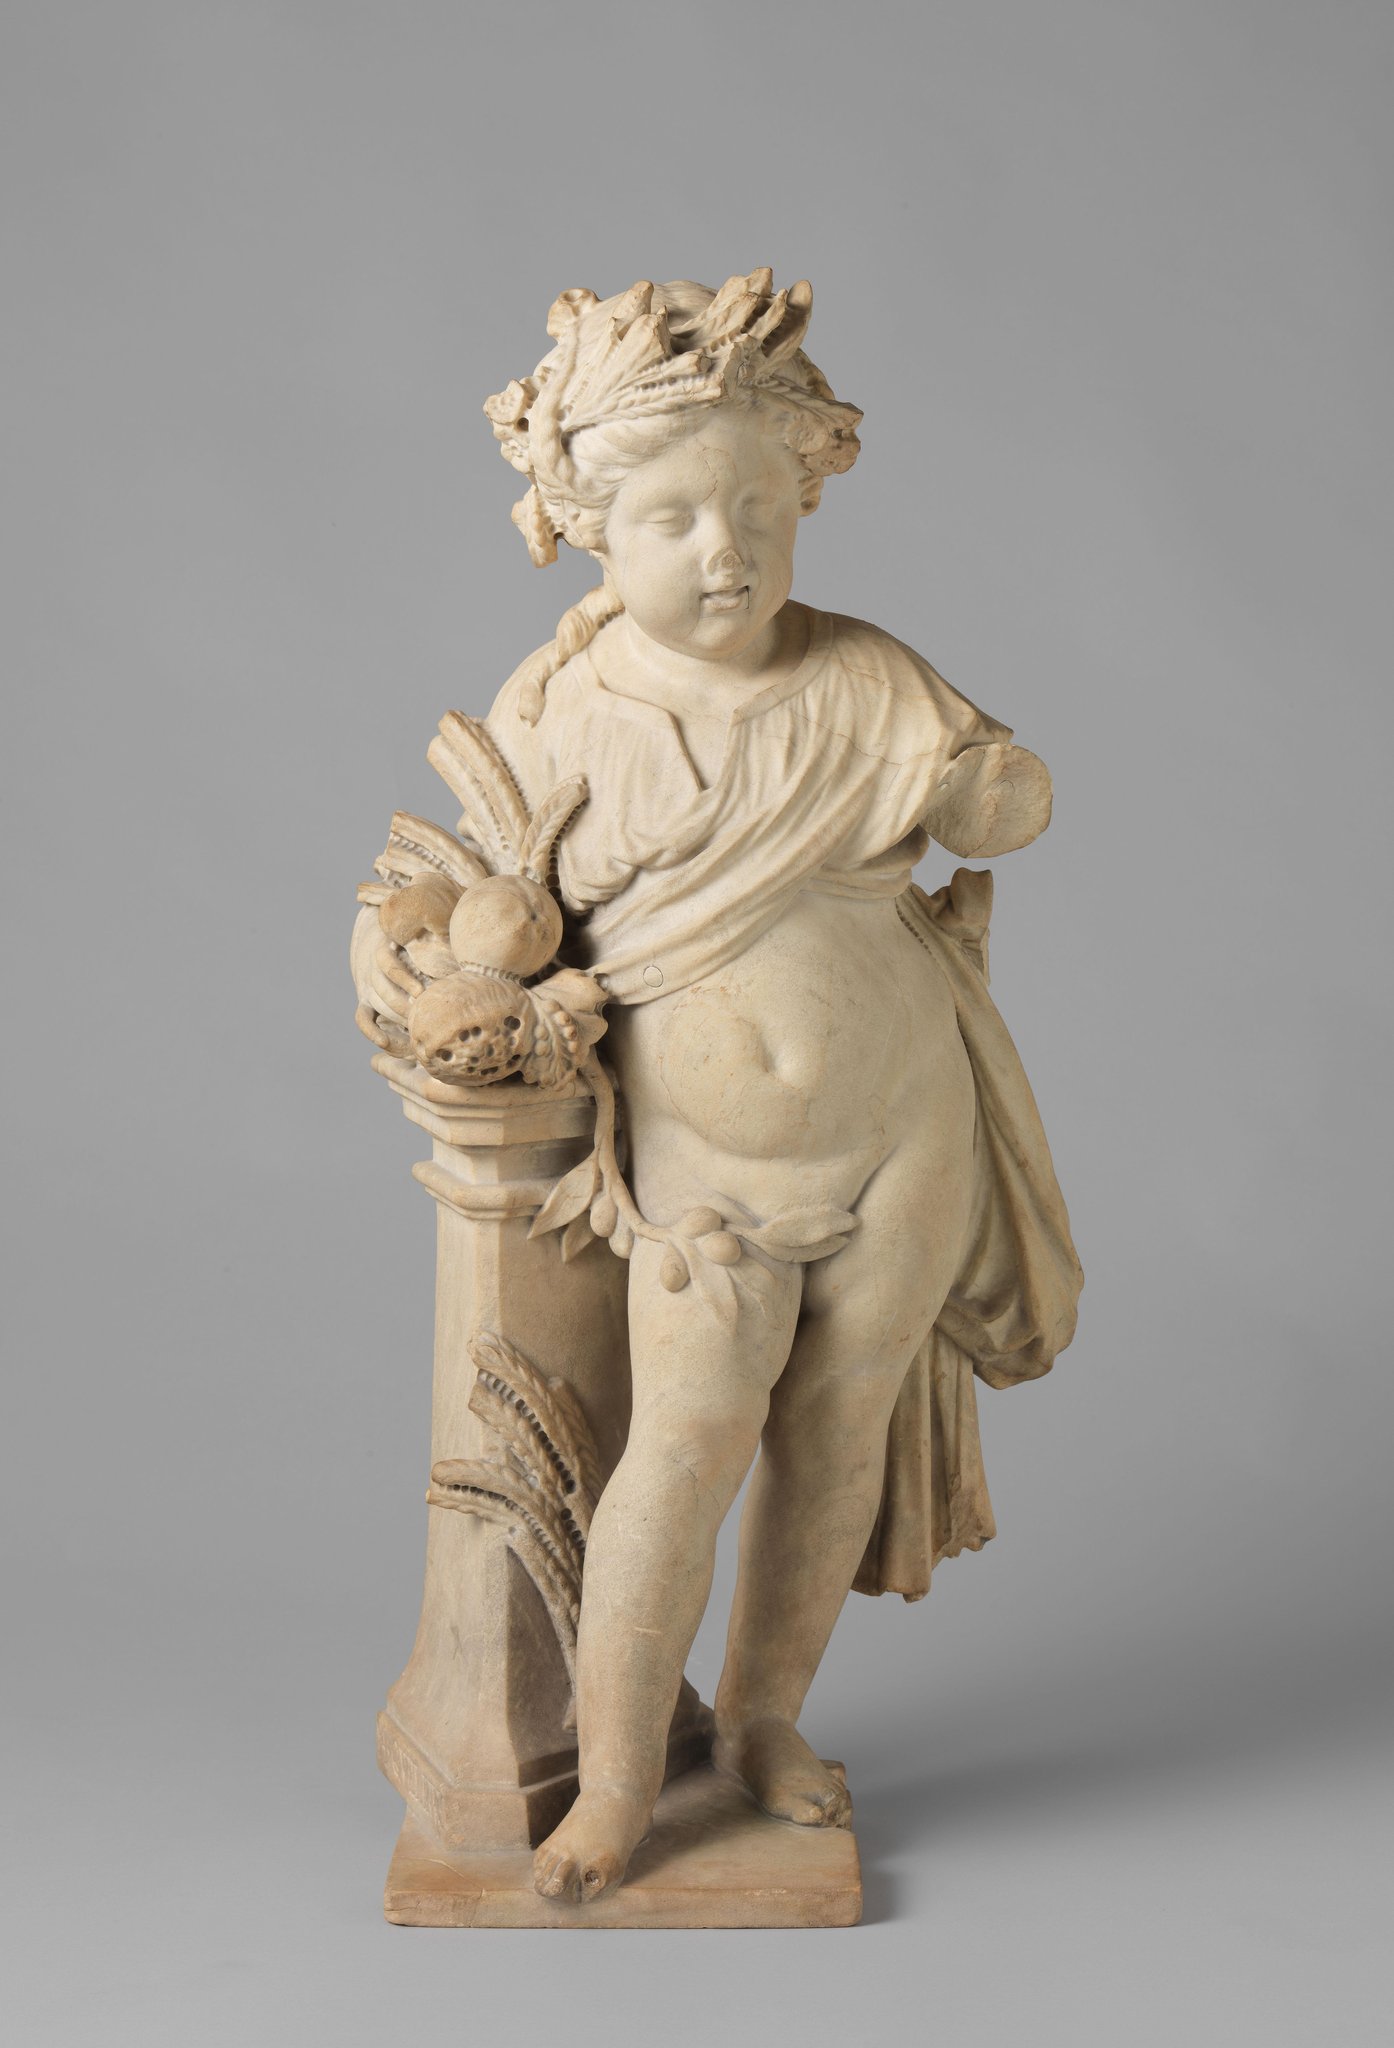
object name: sculpture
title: Summer, from a Series of the Four Seasons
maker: artus quellinus (ii)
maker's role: print maker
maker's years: 1625-1700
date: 1680-1690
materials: marble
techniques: carved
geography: antwerp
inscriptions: signature, on the base of the pedestal, incised: ‘A· QVELINVS’